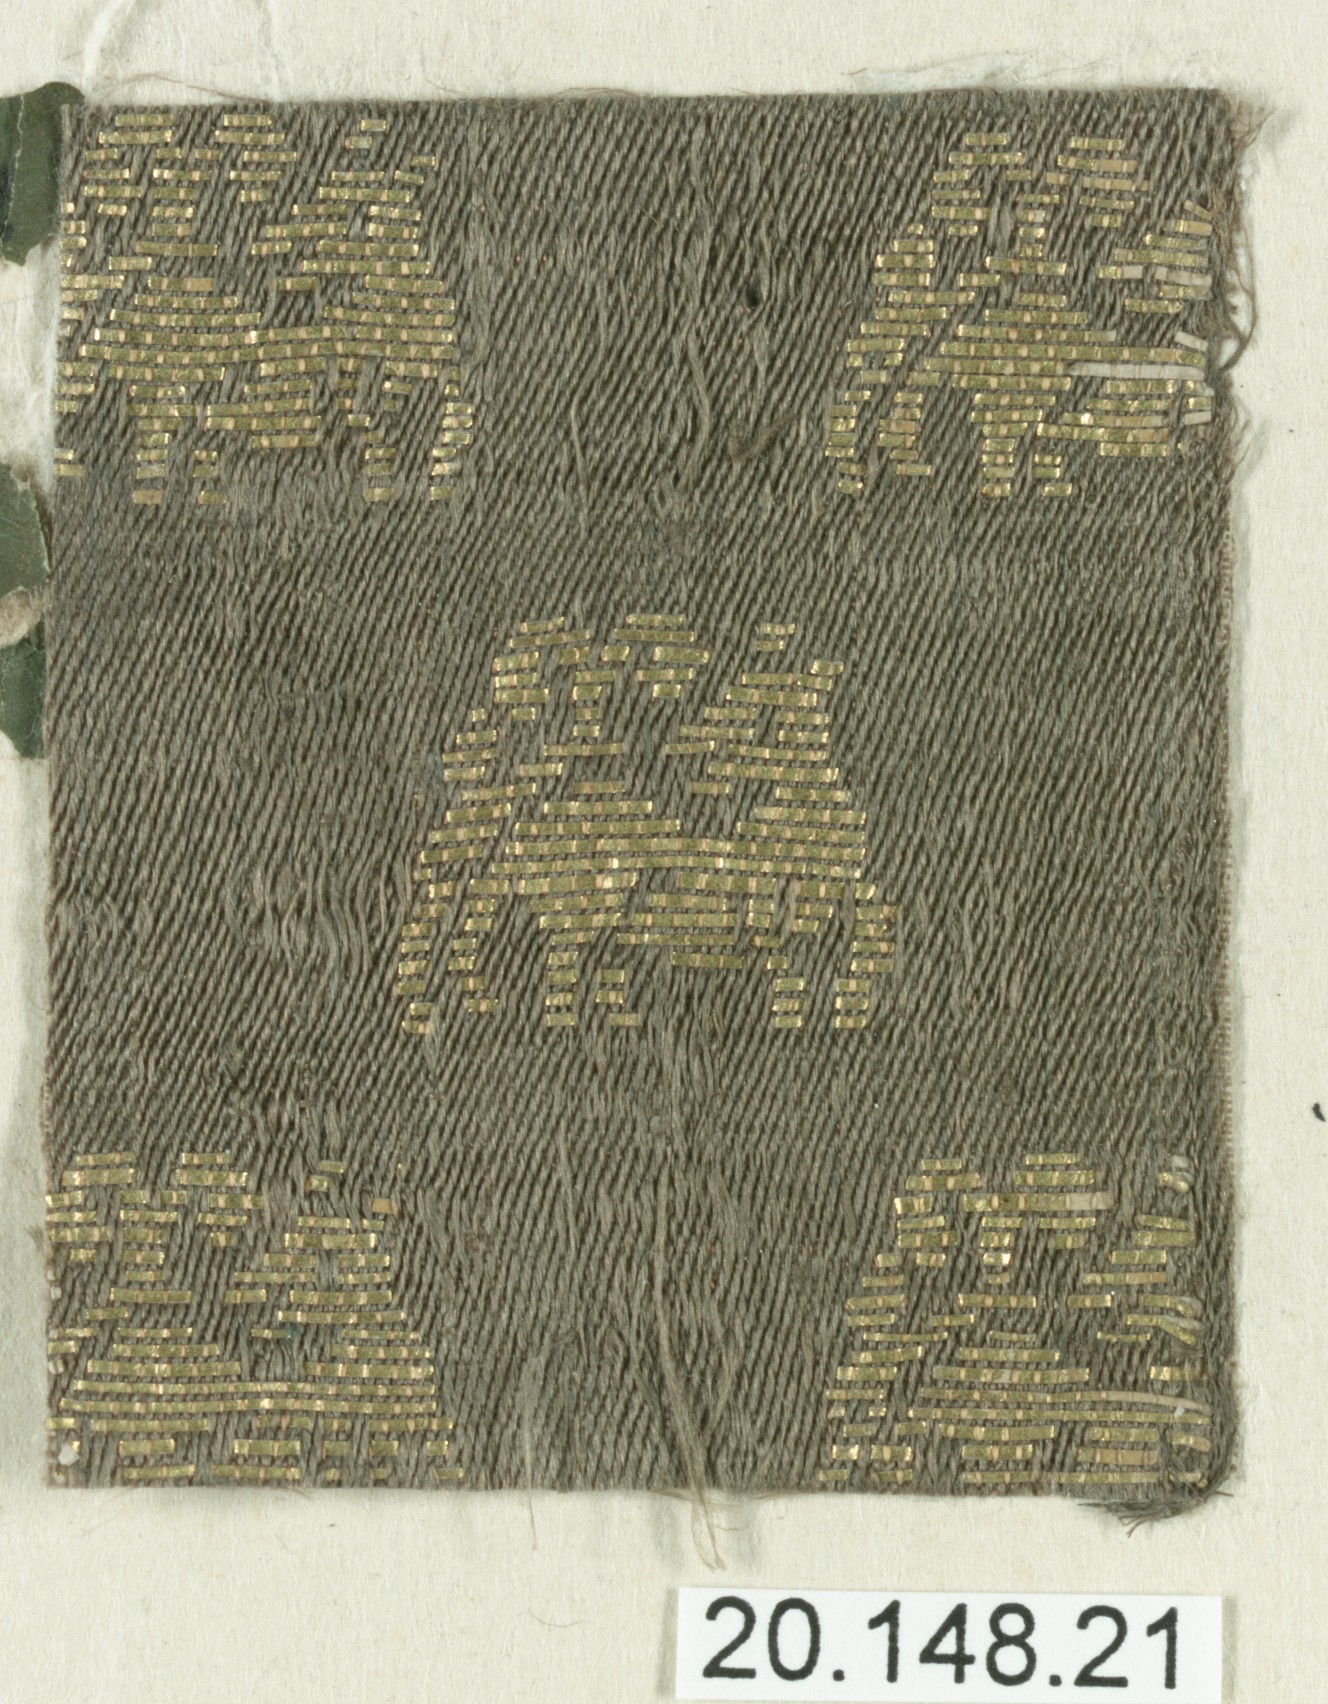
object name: piece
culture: japanese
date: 1301-1400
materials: silk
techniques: compound weave